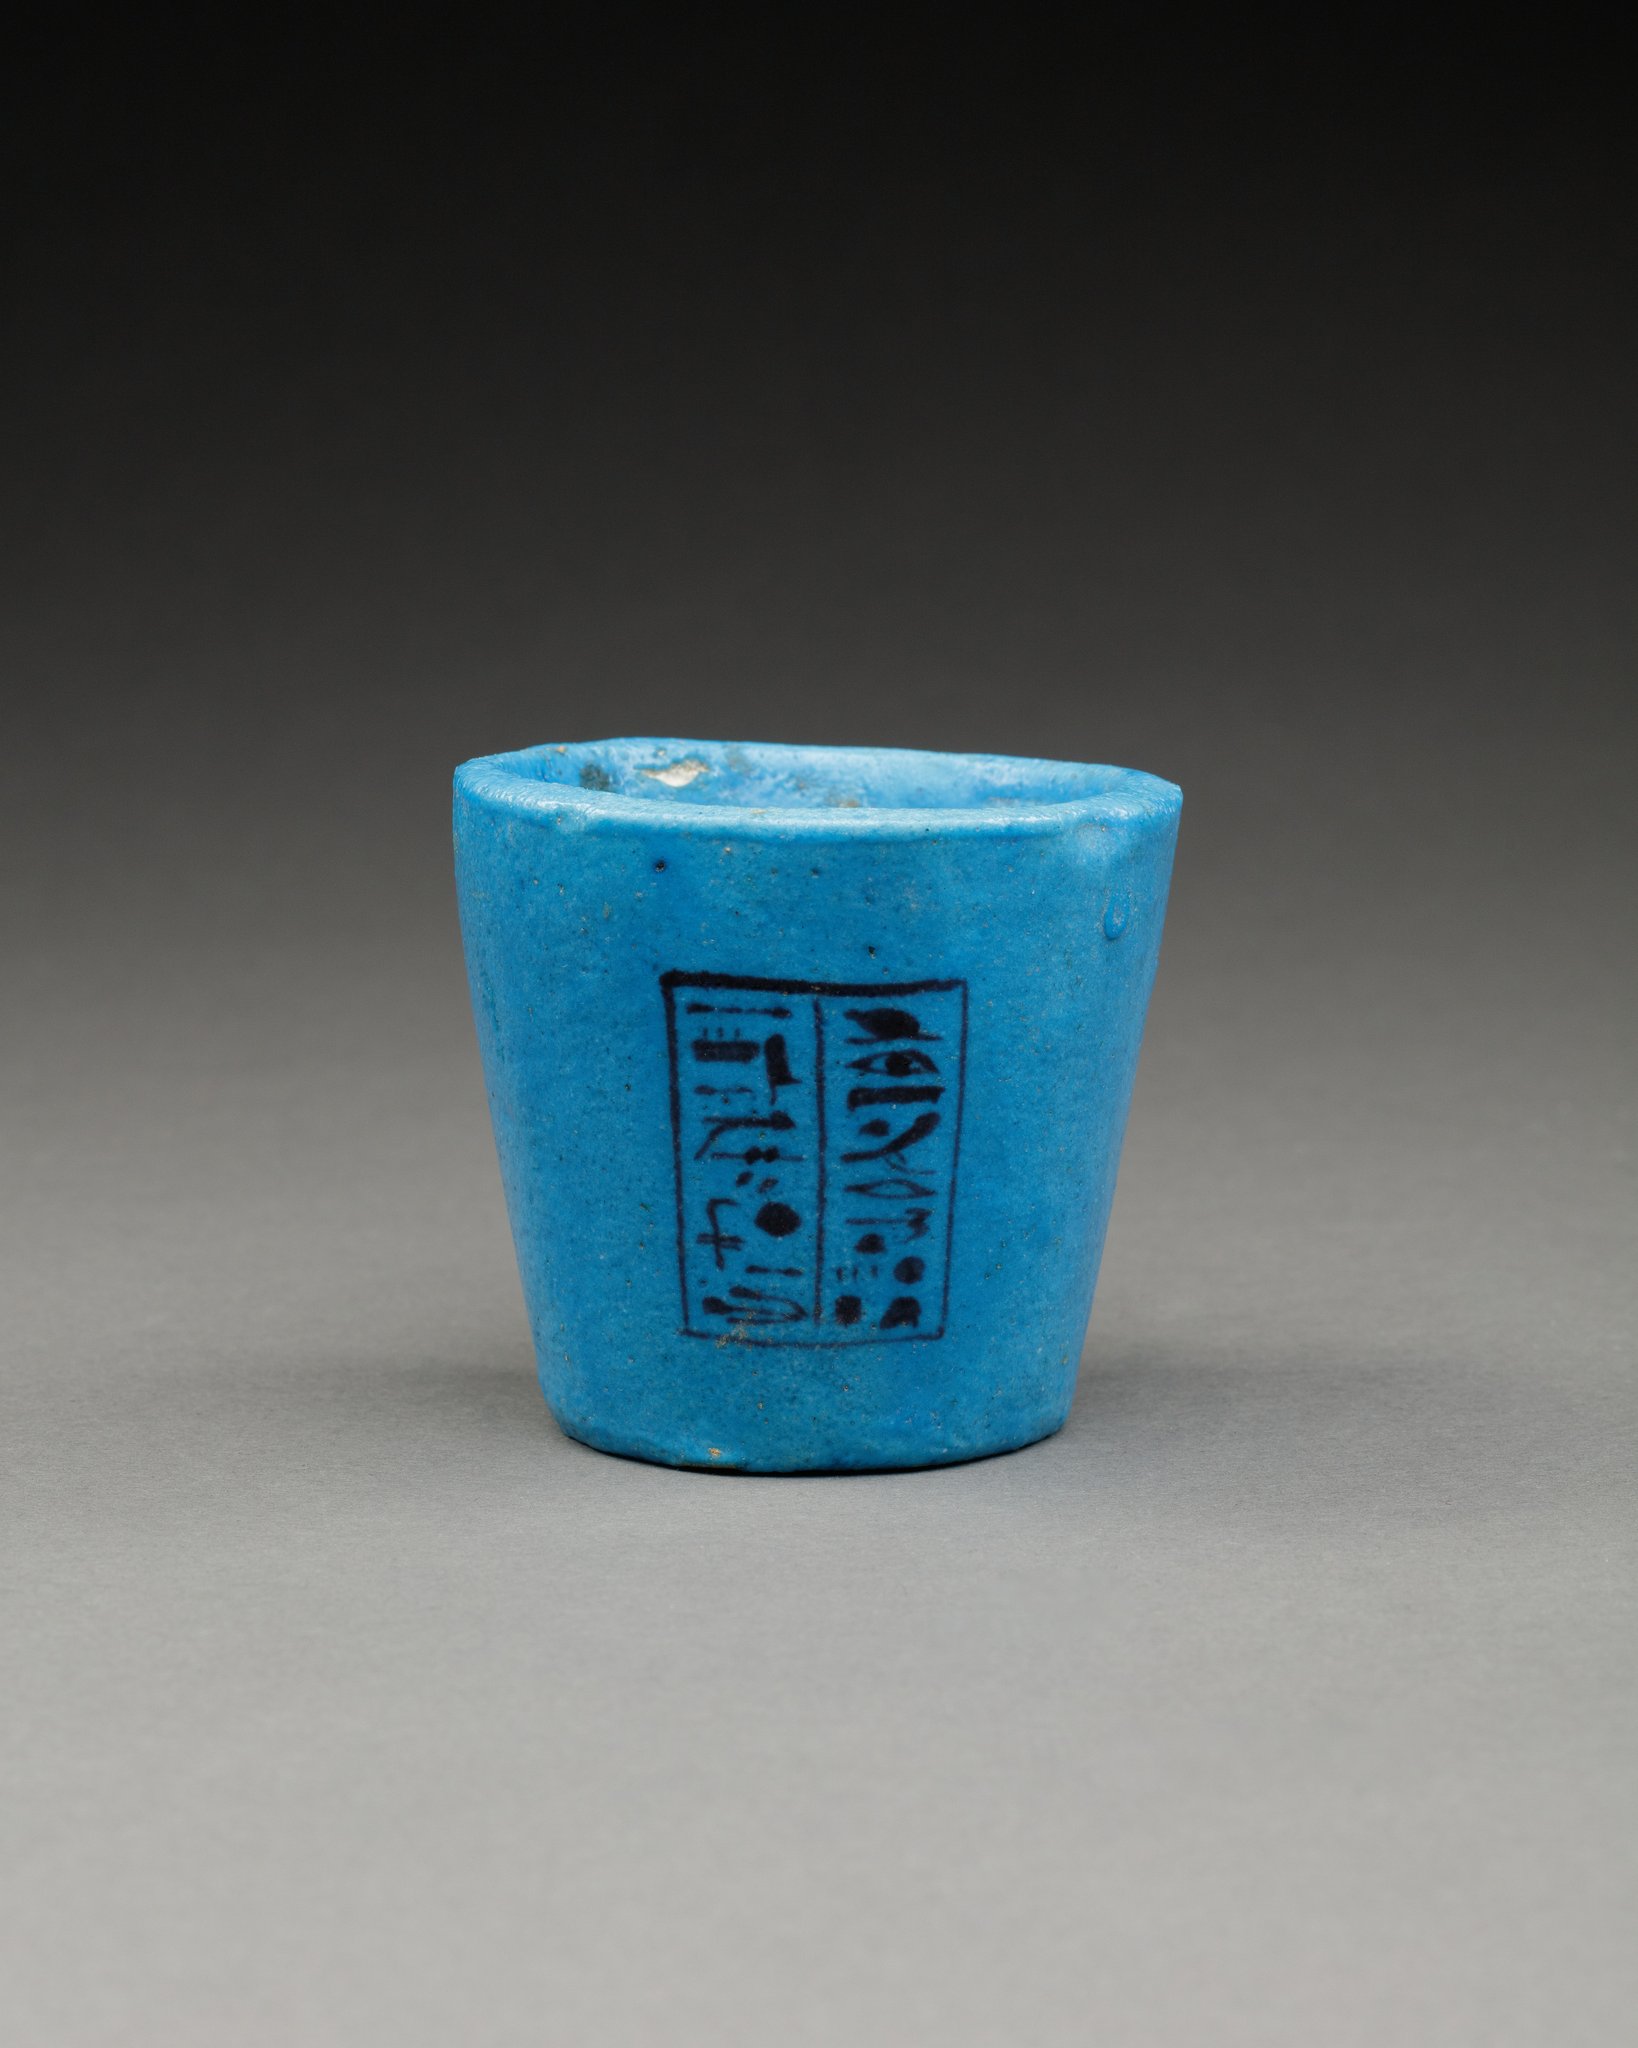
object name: cup, nesikhonsu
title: Cup of Nesikhonsu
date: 990-969 BCE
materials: faience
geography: upper egypt, thebes